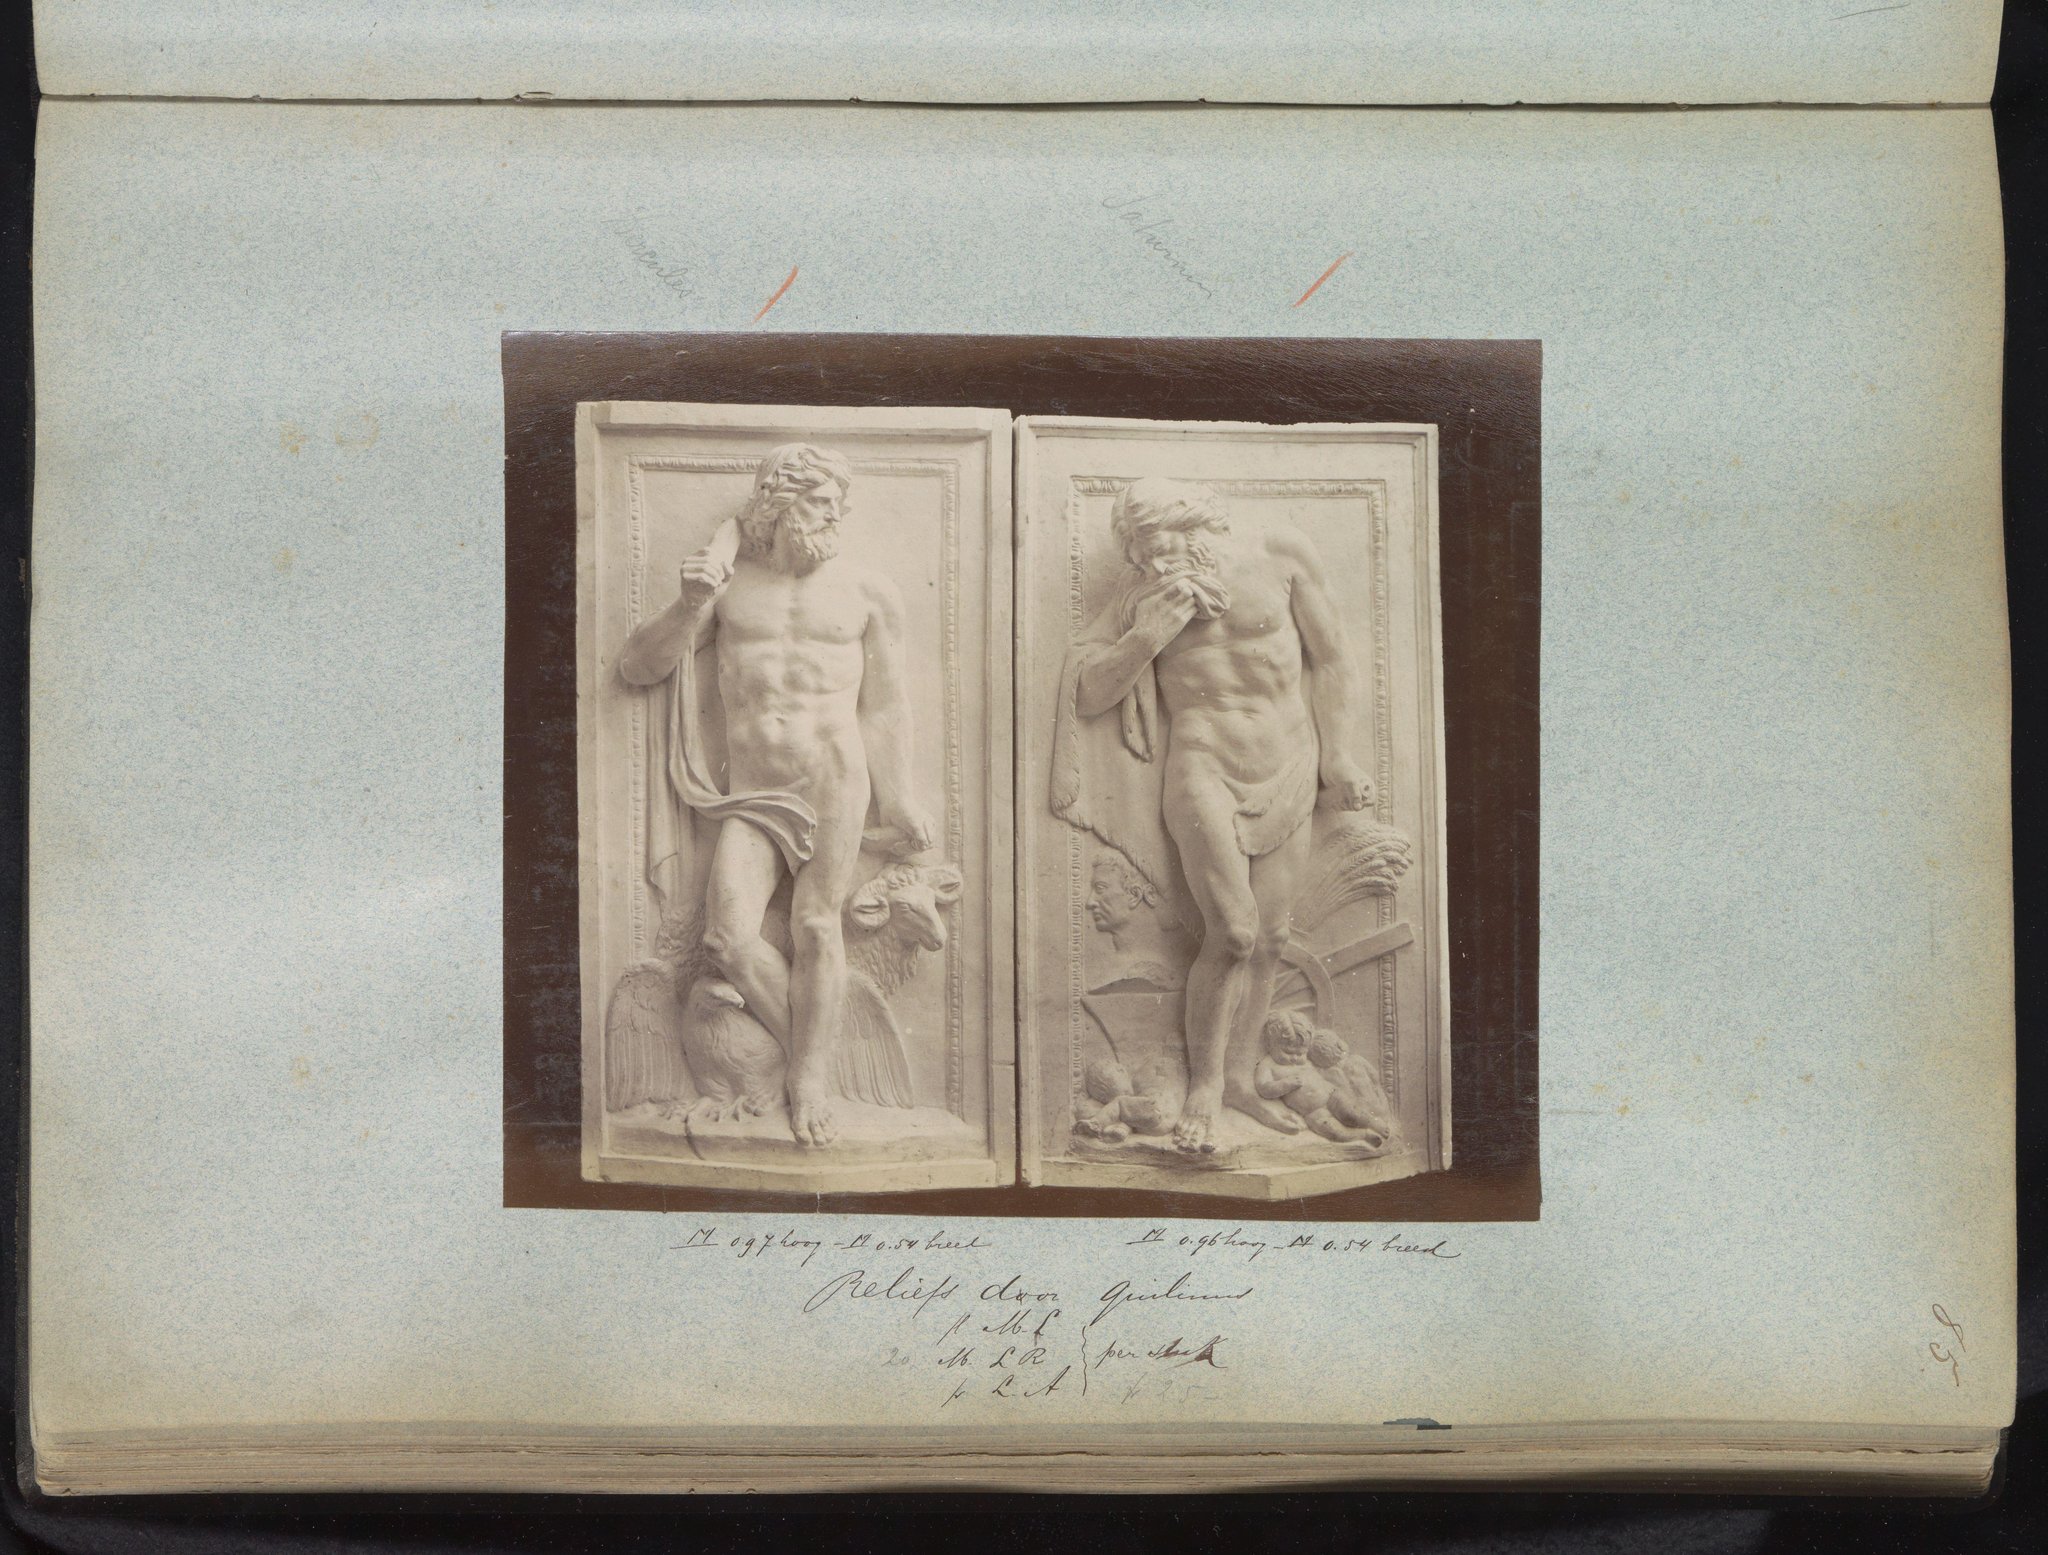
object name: album leaf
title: Twee gipsen afgietsels van reliëfs van Hercules en Saturnus door Quellinus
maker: Anonymous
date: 1875-1900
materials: paper, photographic support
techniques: albumen print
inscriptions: annotation: ‘Reliëfs door Quilinus’, annotation, annotation: ‘Heracles Saturnus’